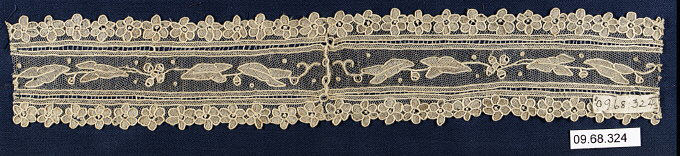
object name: insertion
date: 1801-1900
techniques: lace